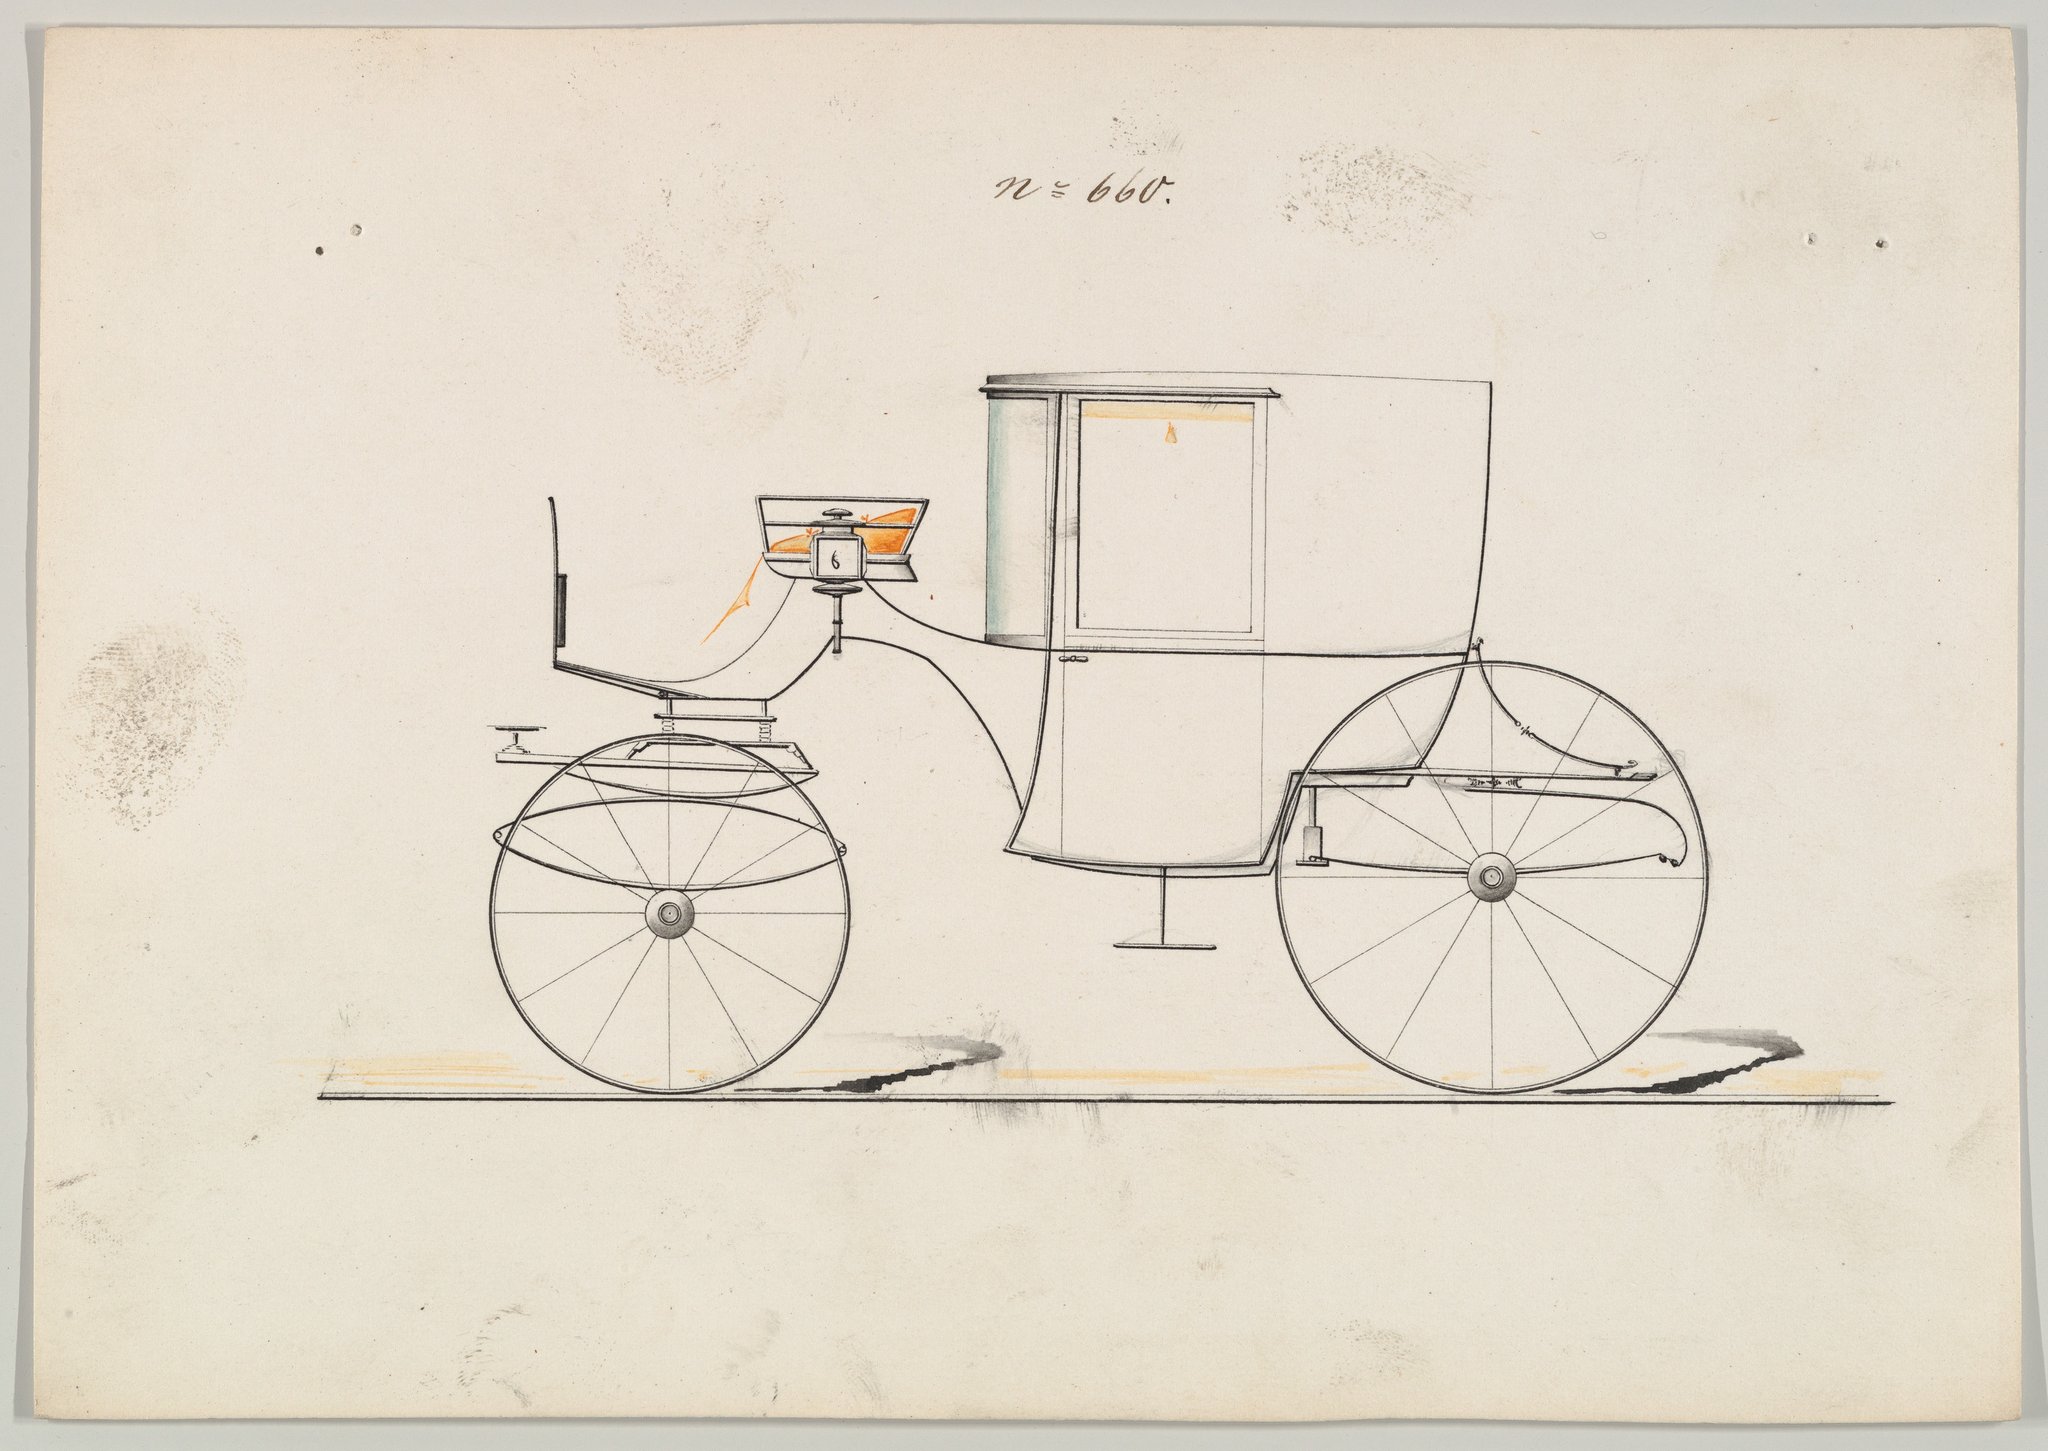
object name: drawing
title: Coupé #660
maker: brewster & co.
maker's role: manufacturer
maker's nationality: american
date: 1850-1870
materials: gouache, watercolor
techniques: pen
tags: carriages